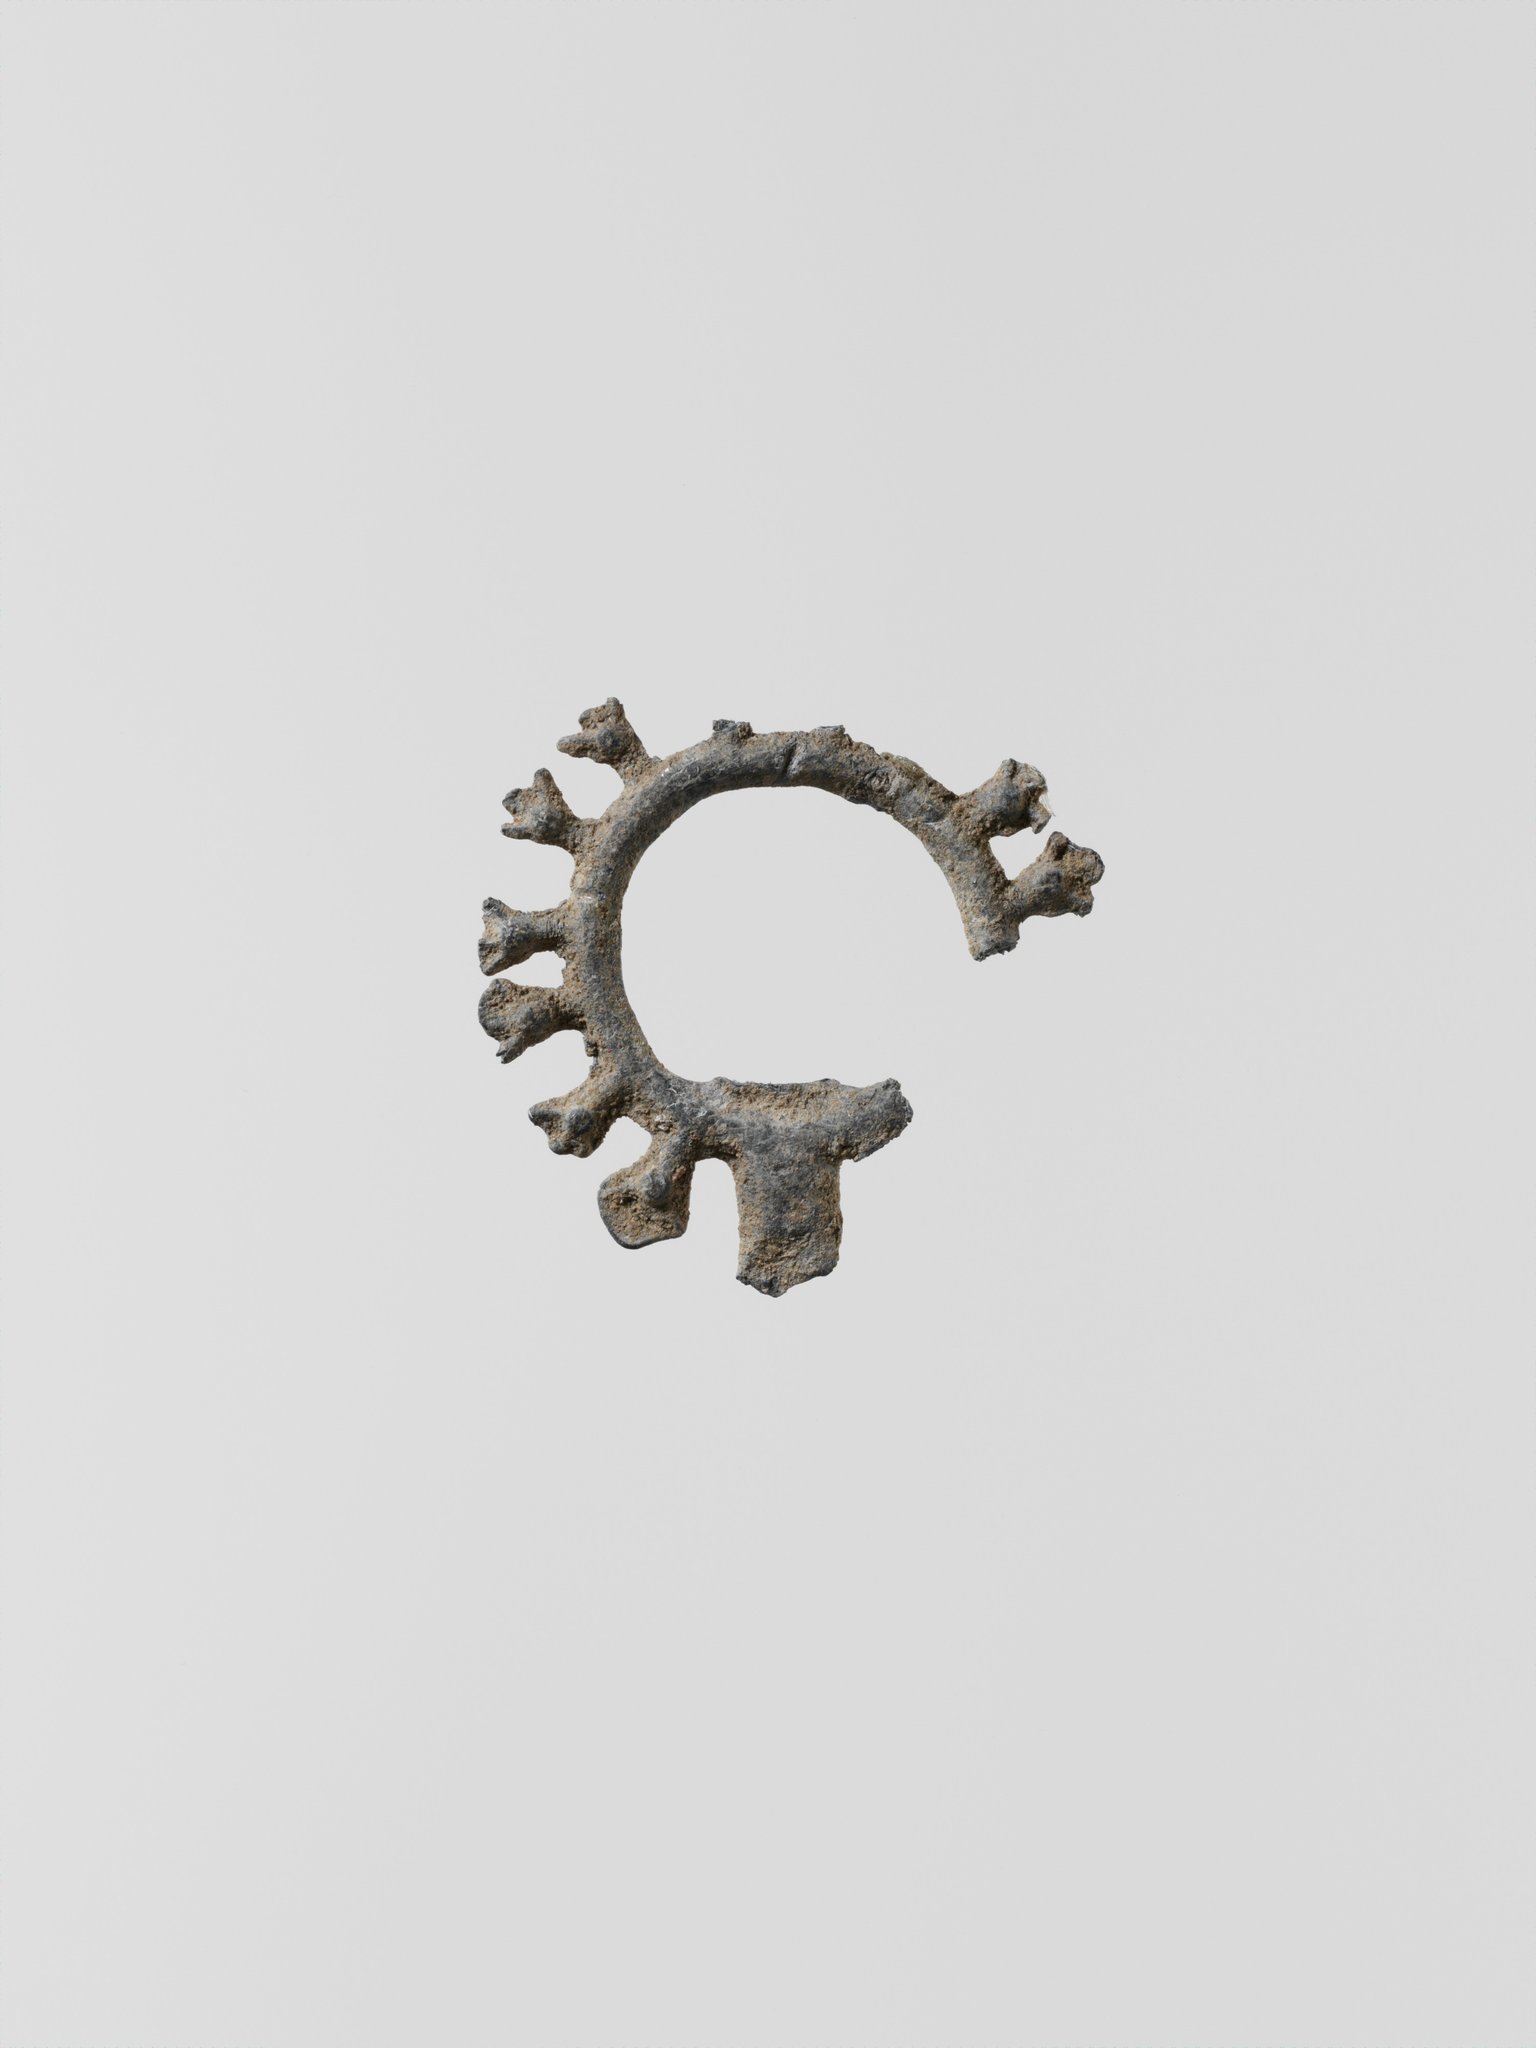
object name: wreath, 6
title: Wreaths, 6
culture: greek, laconian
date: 7000-30 BCE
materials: lead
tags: wreaths